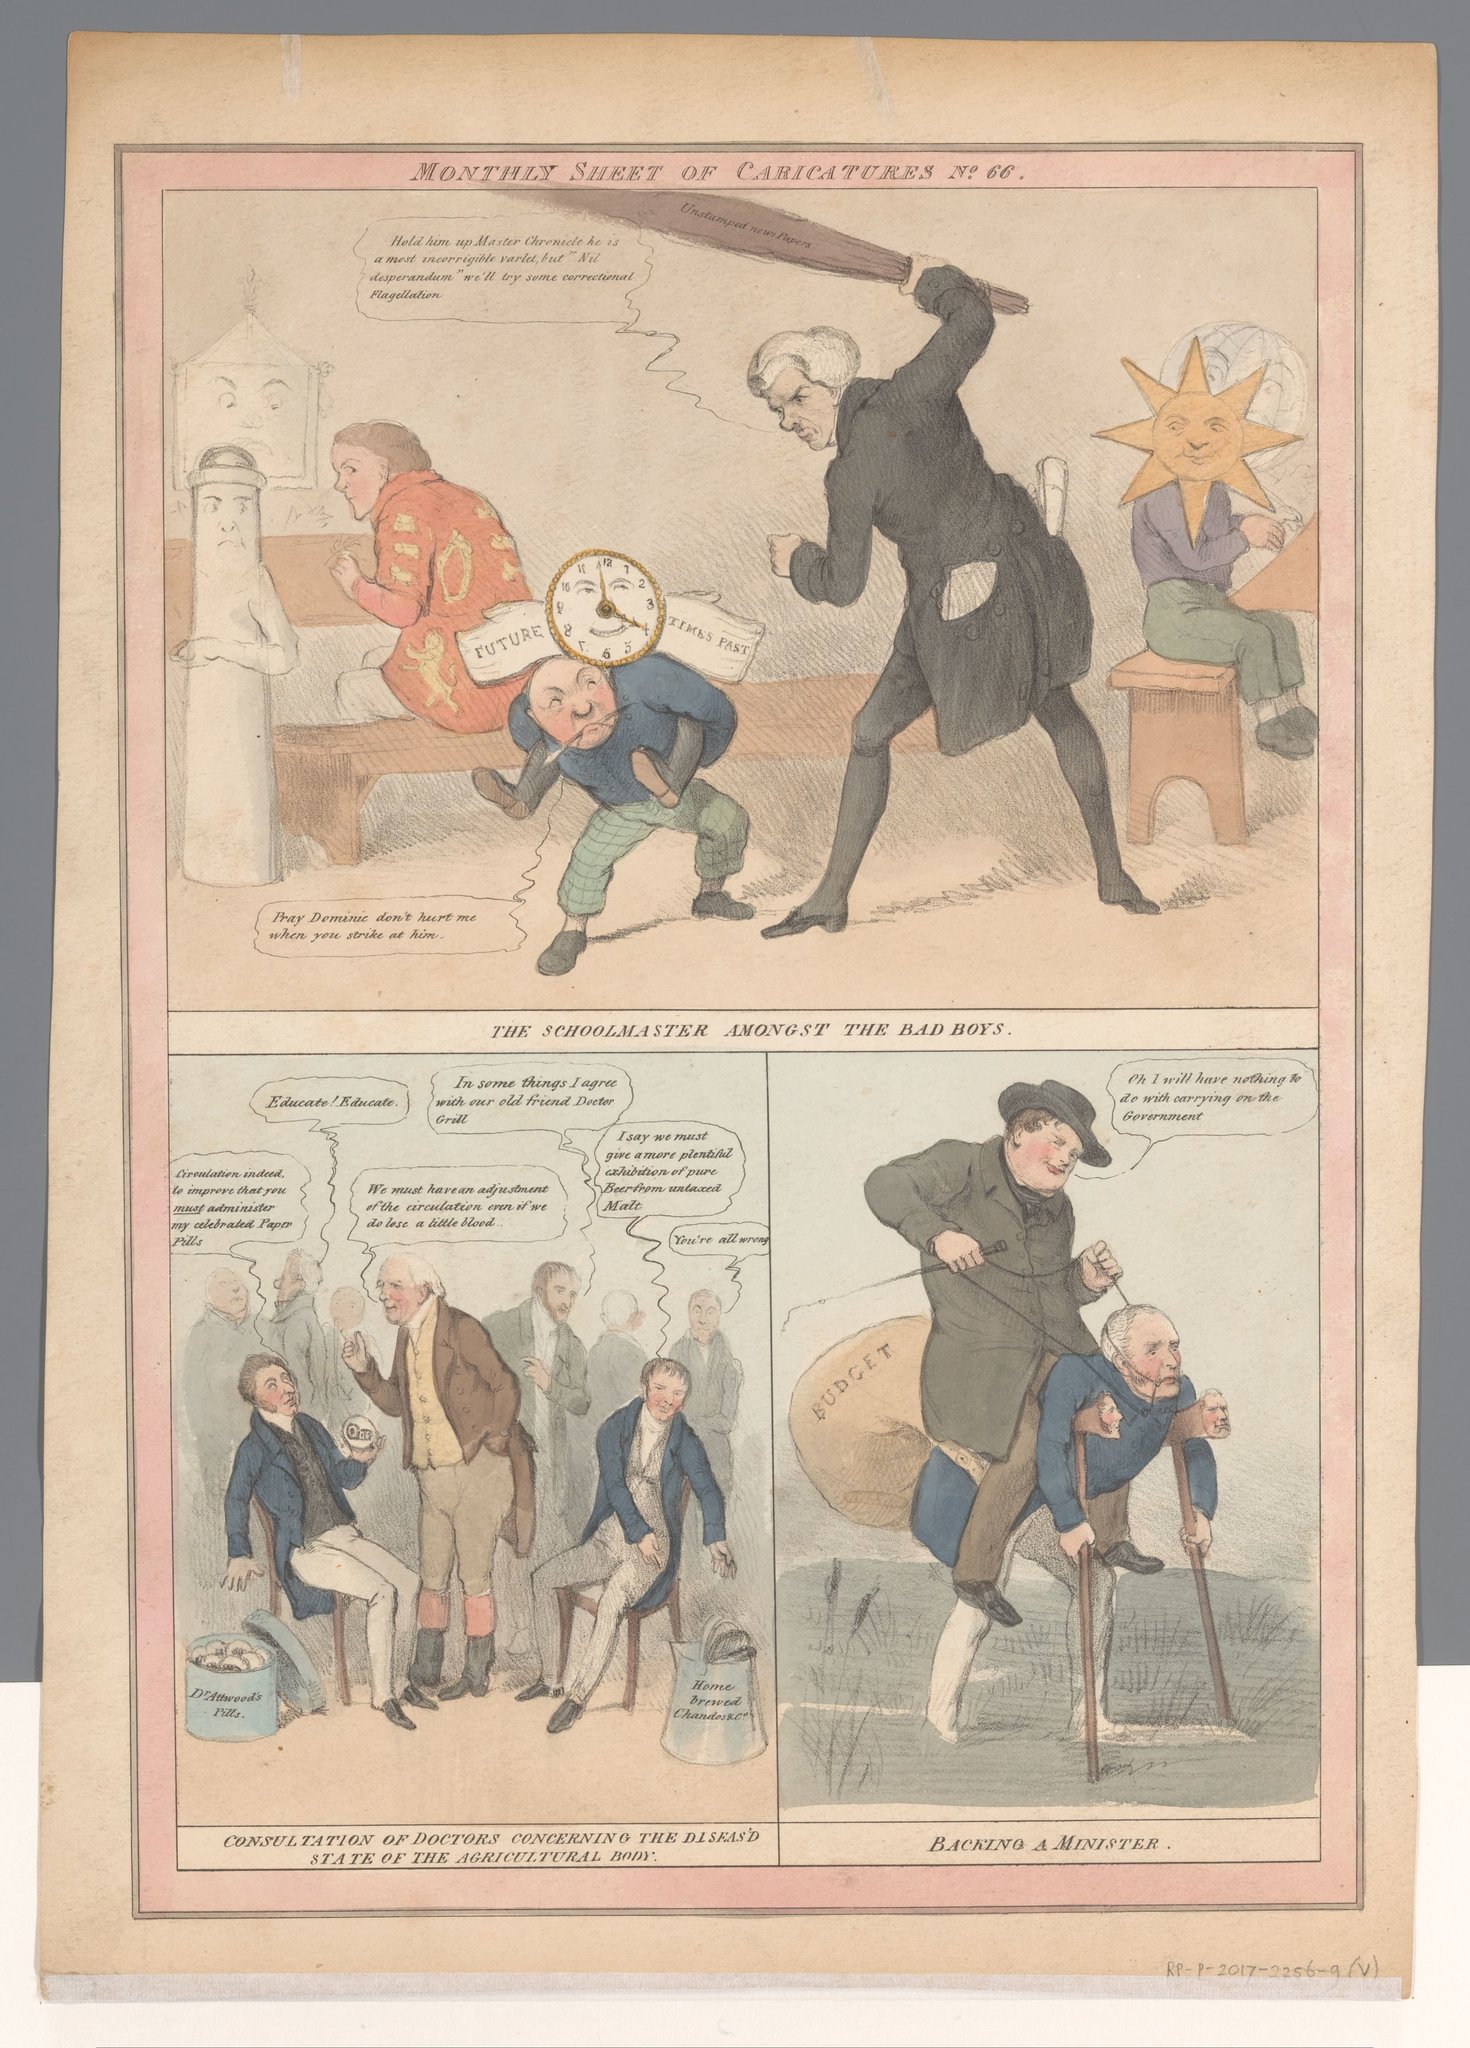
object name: print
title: Spotprent over de Engelse binnenlandse politiek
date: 1830-1840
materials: paper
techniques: hand coloring, lithograph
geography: england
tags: crutches, corporal punishment at school: castigating, beating, etc., carrying a person on one's back, political caricatures and satires